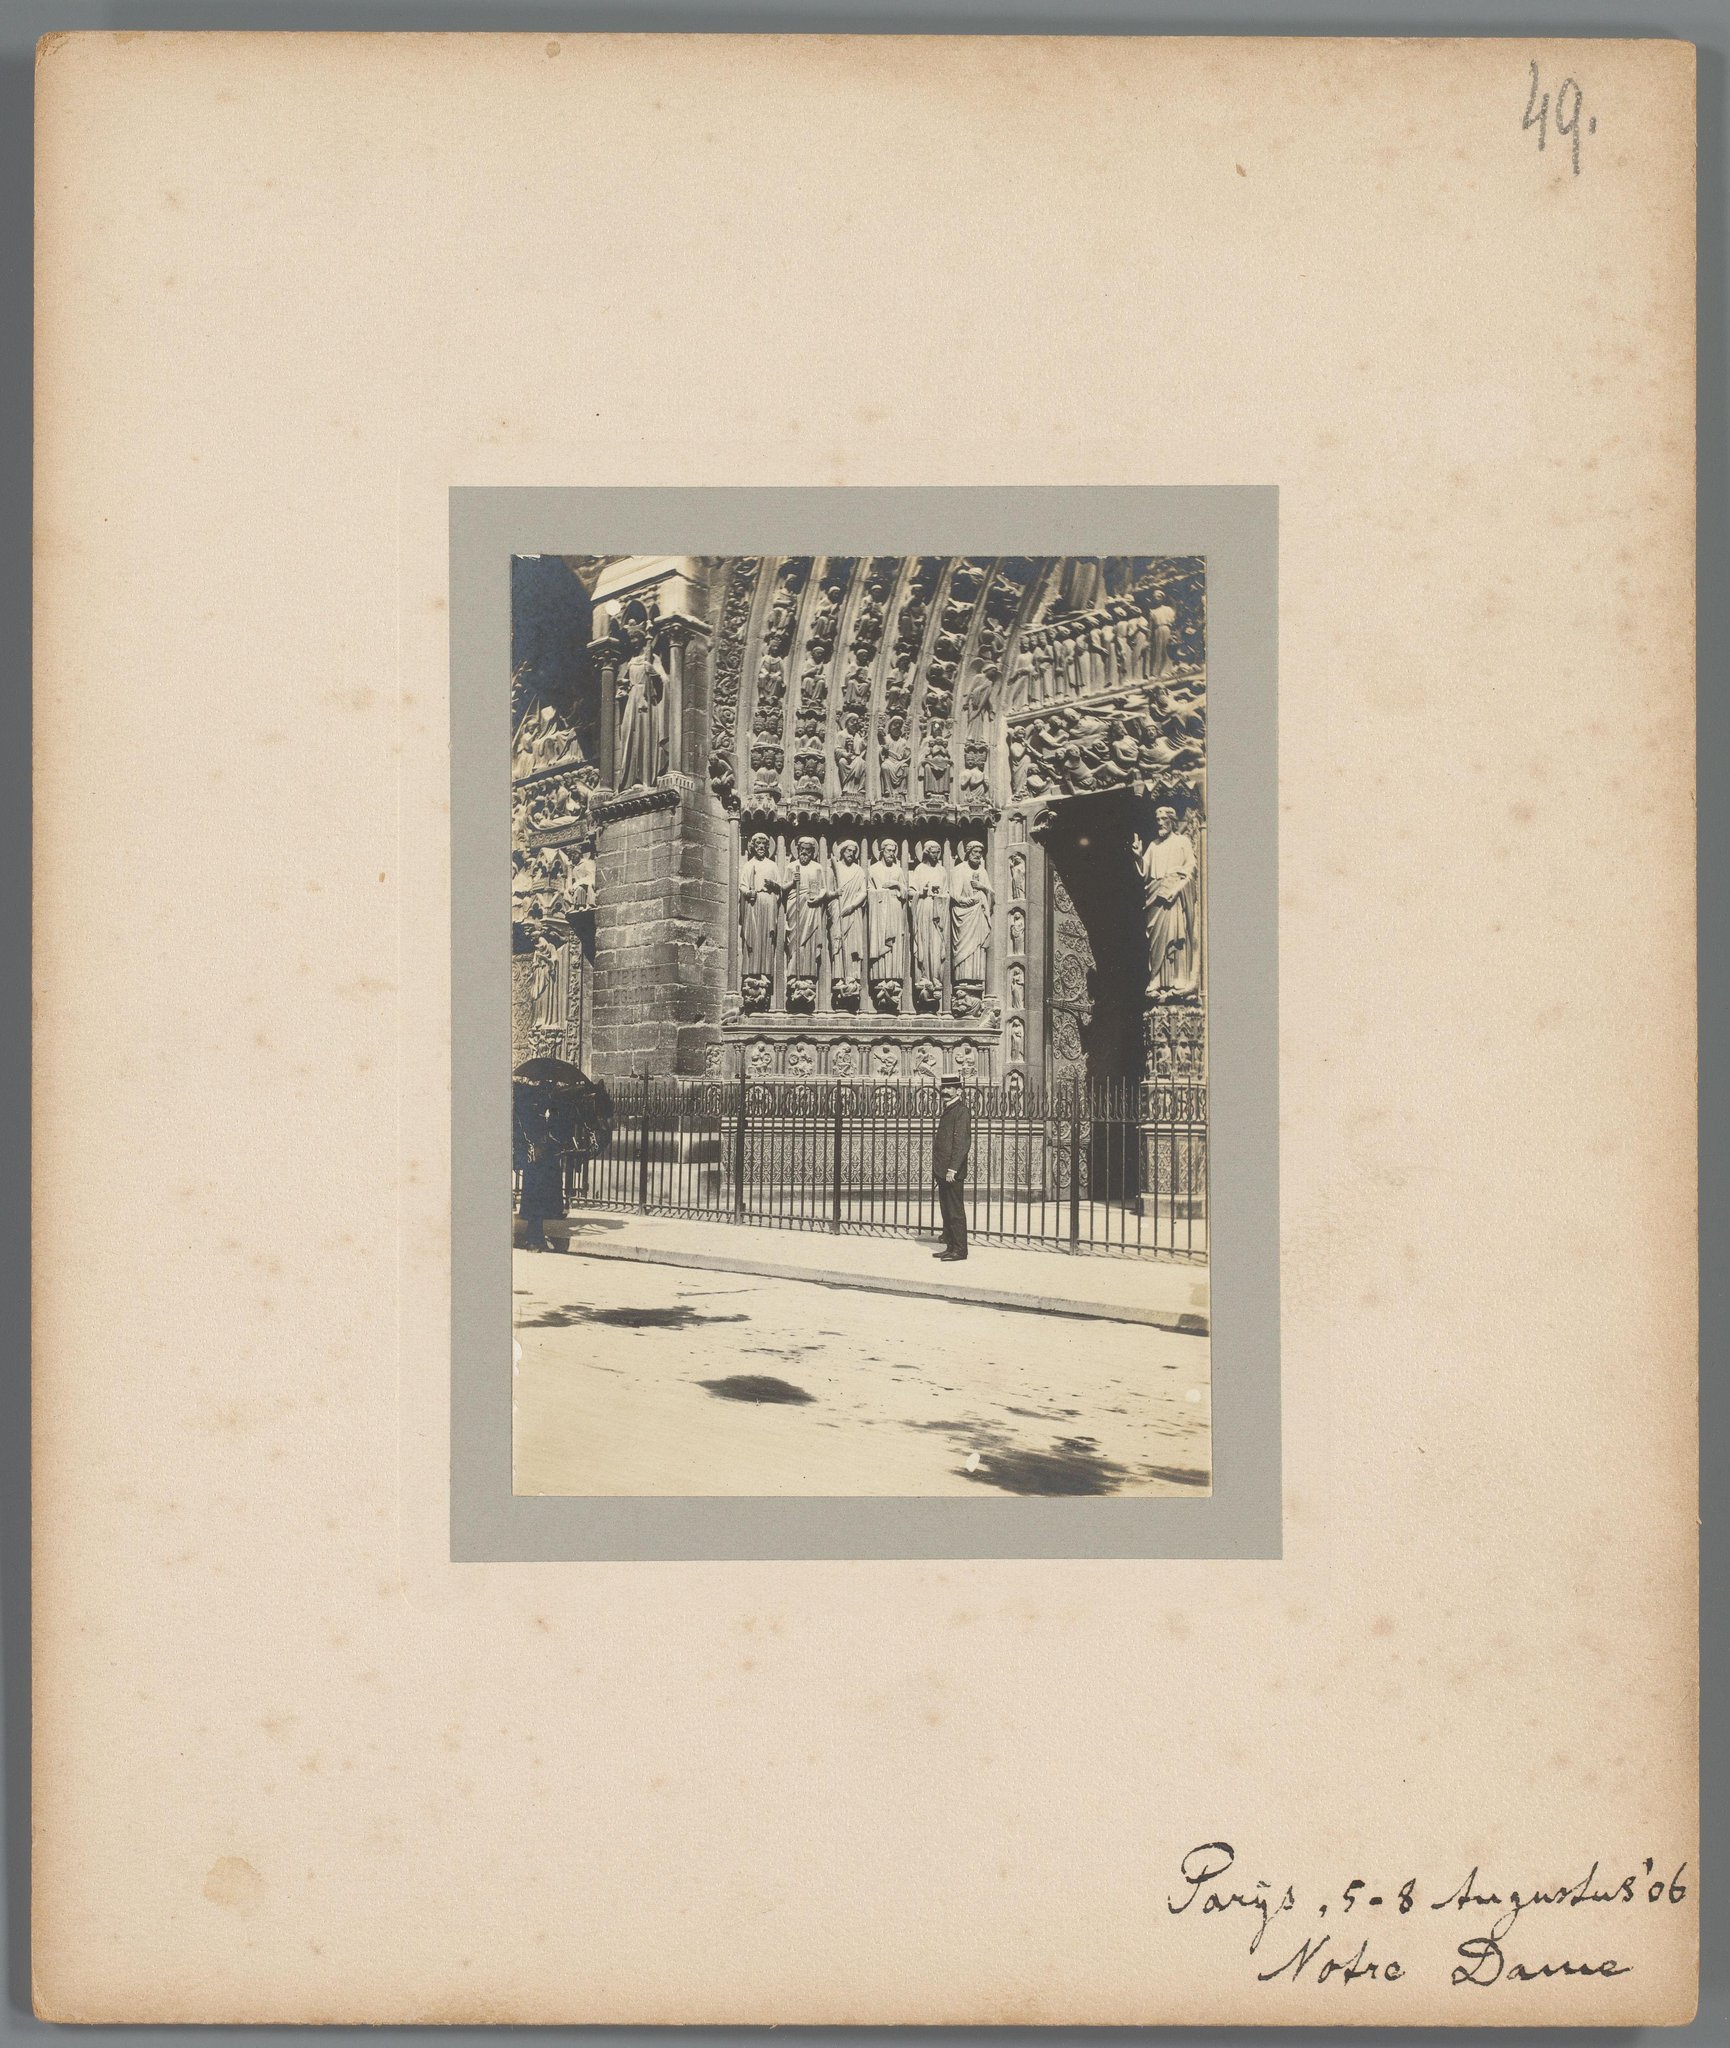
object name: photograph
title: Man voor een portaal van de Notre Dame in Parijs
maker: françois buys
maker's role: advocaat, amateurfotograaf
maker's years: 1871-1934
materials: paper, cardboard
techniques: gelatin silver print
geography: paris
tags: parts of church exterior and annexes: portal, historical persons not known by name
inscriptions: number: ‘49’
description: Deze foto maakt deel uit van een groep van 49 foto's.